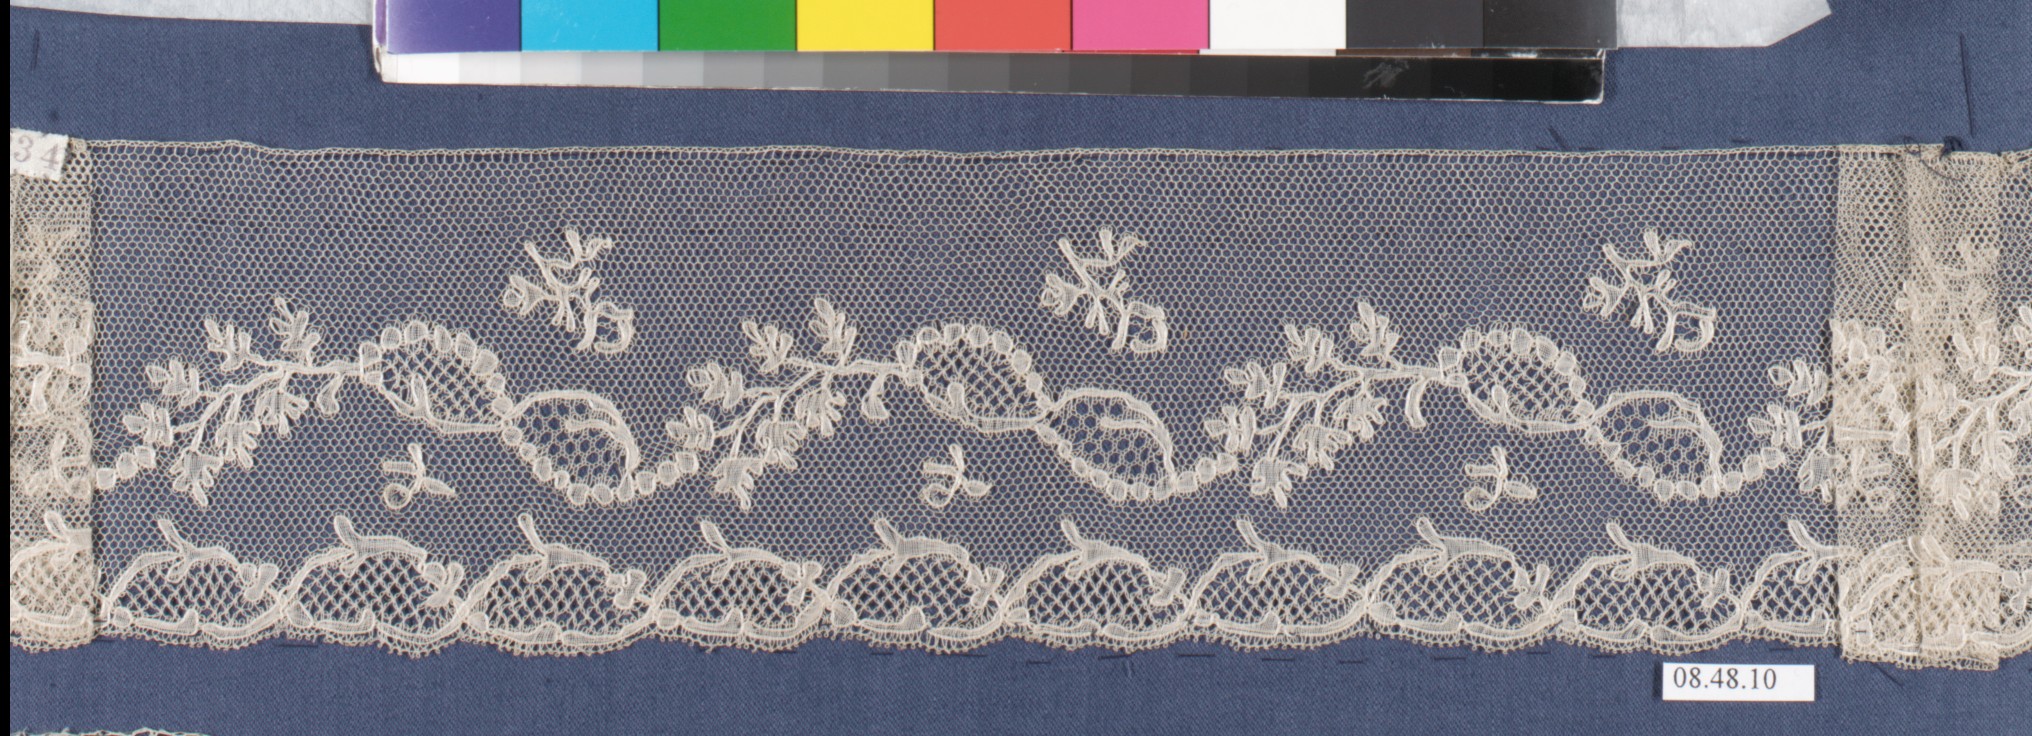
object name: edging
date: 1850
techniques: lace